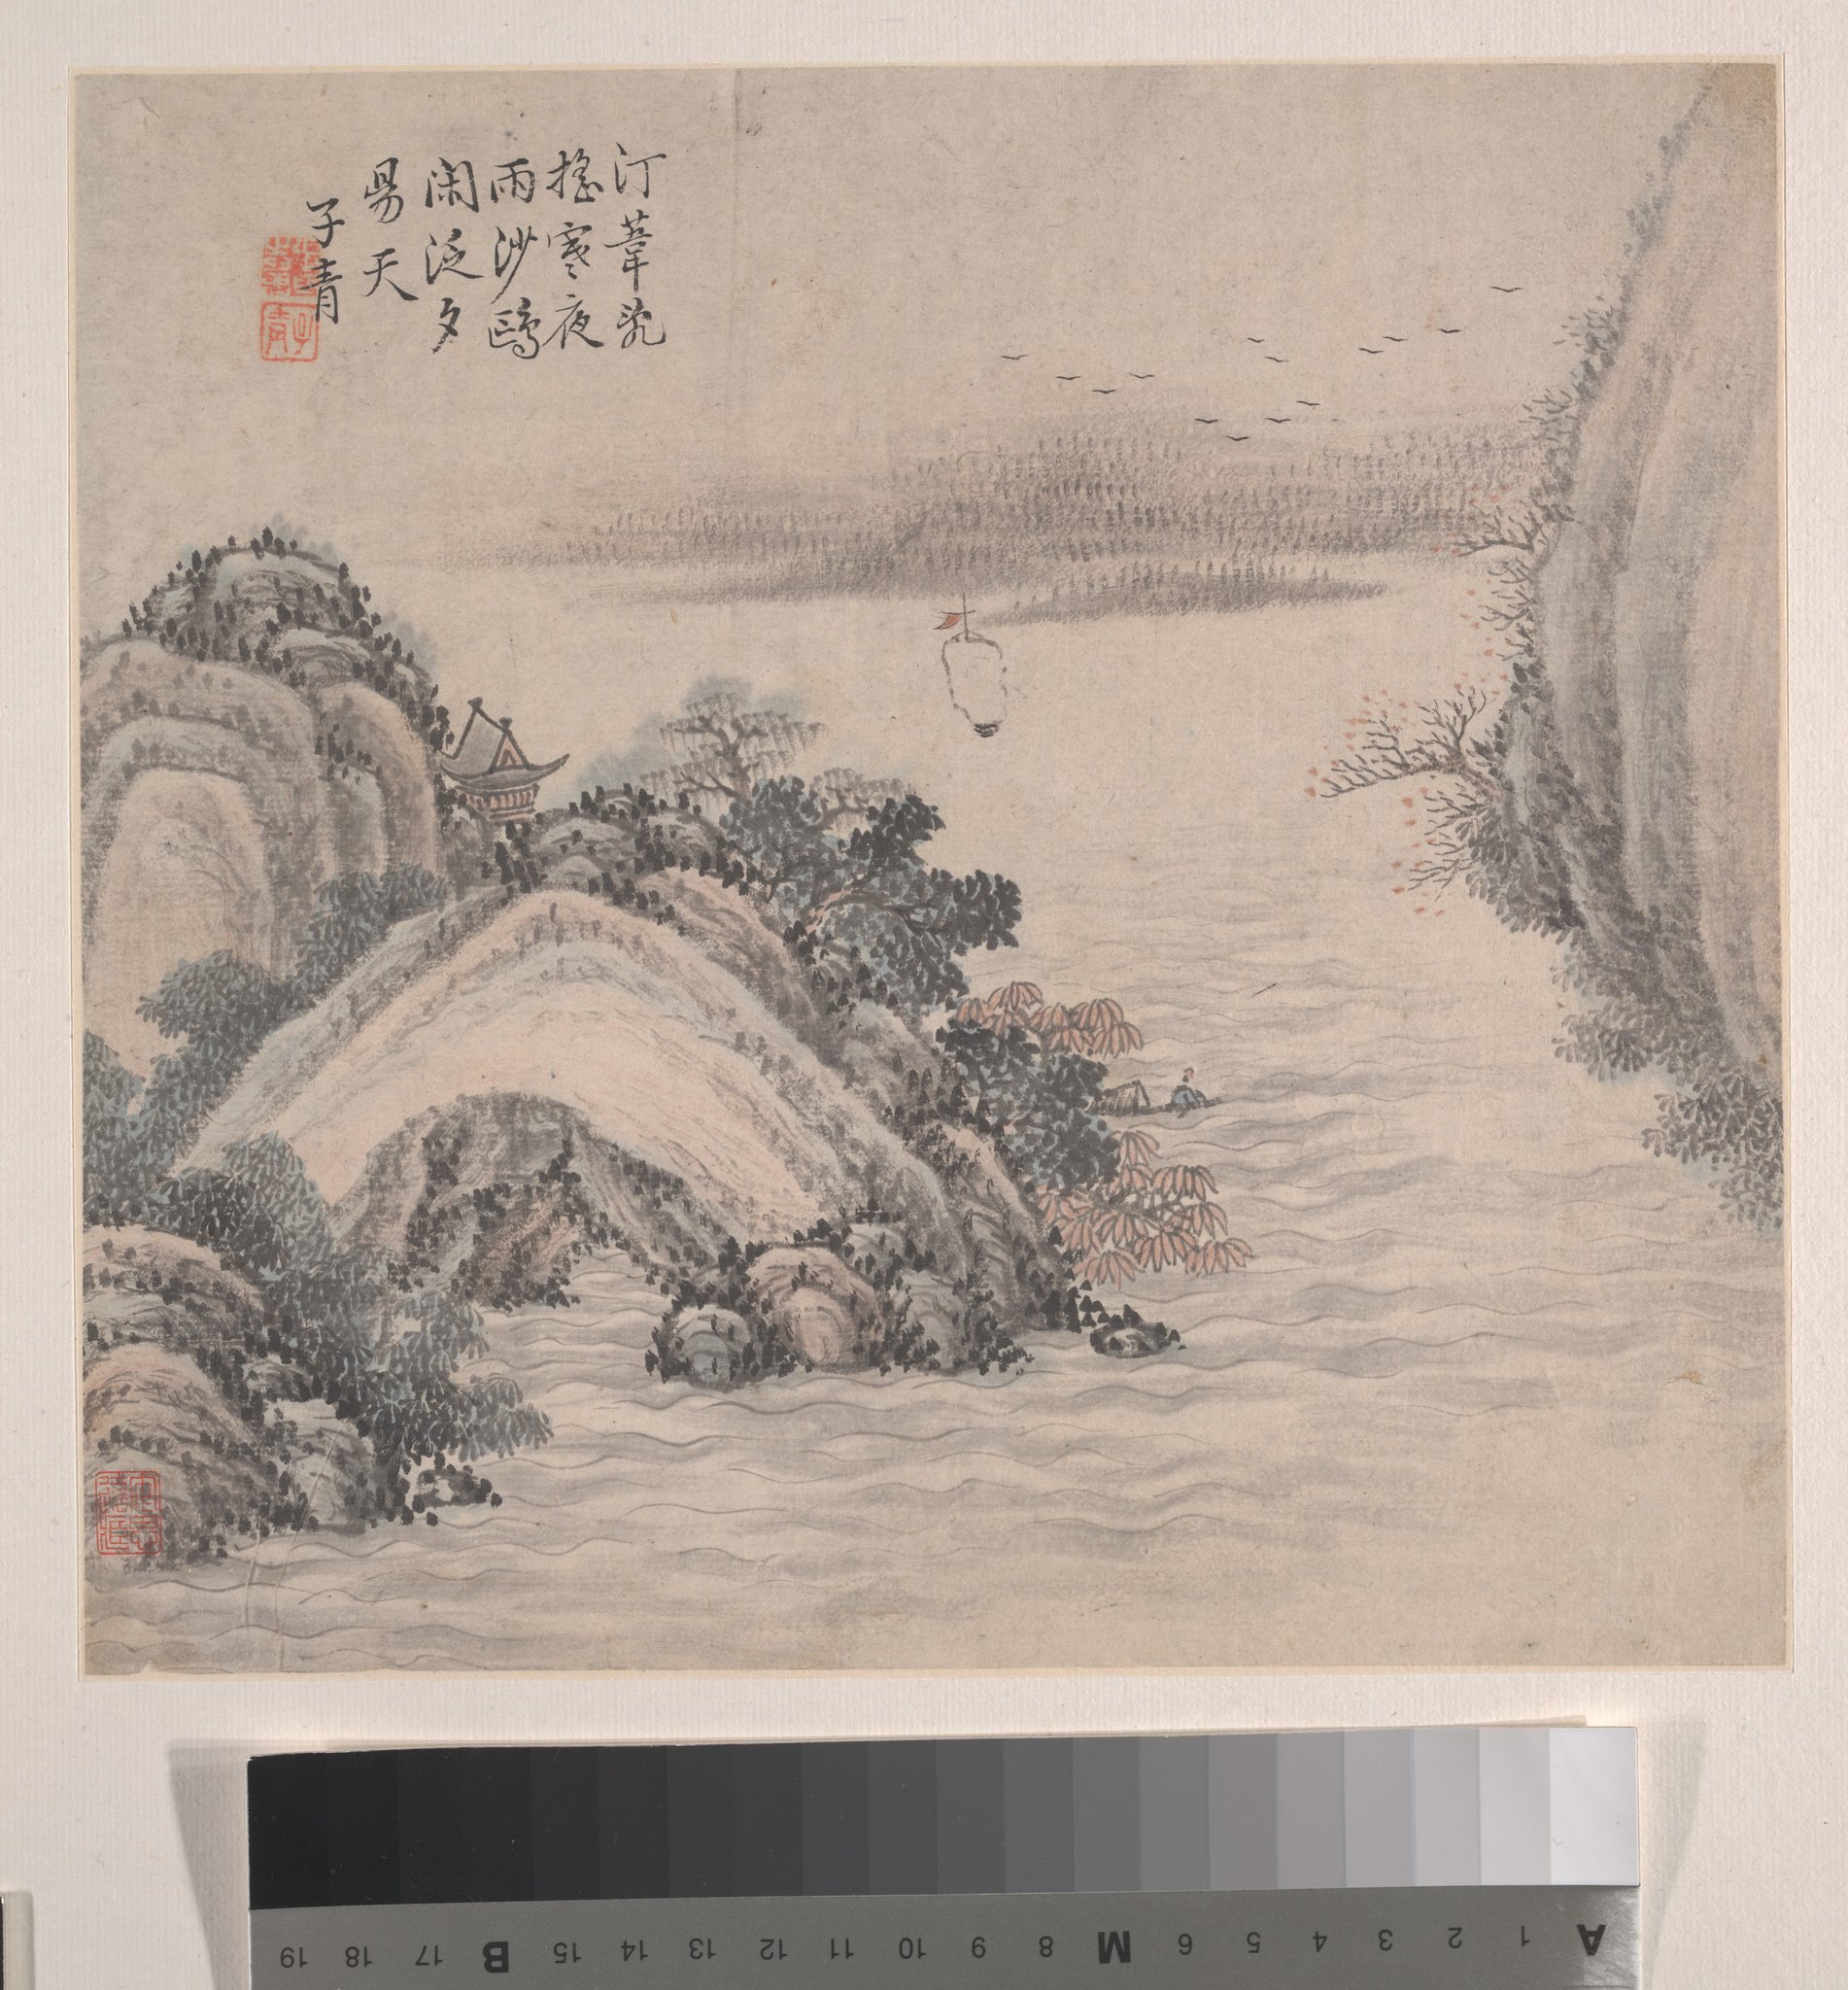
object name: album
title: Landscapes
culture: chinese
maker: zhang zhiwan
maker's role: artist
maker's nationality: chinese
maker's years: 1811-1897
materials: ink, paper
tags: landscapes